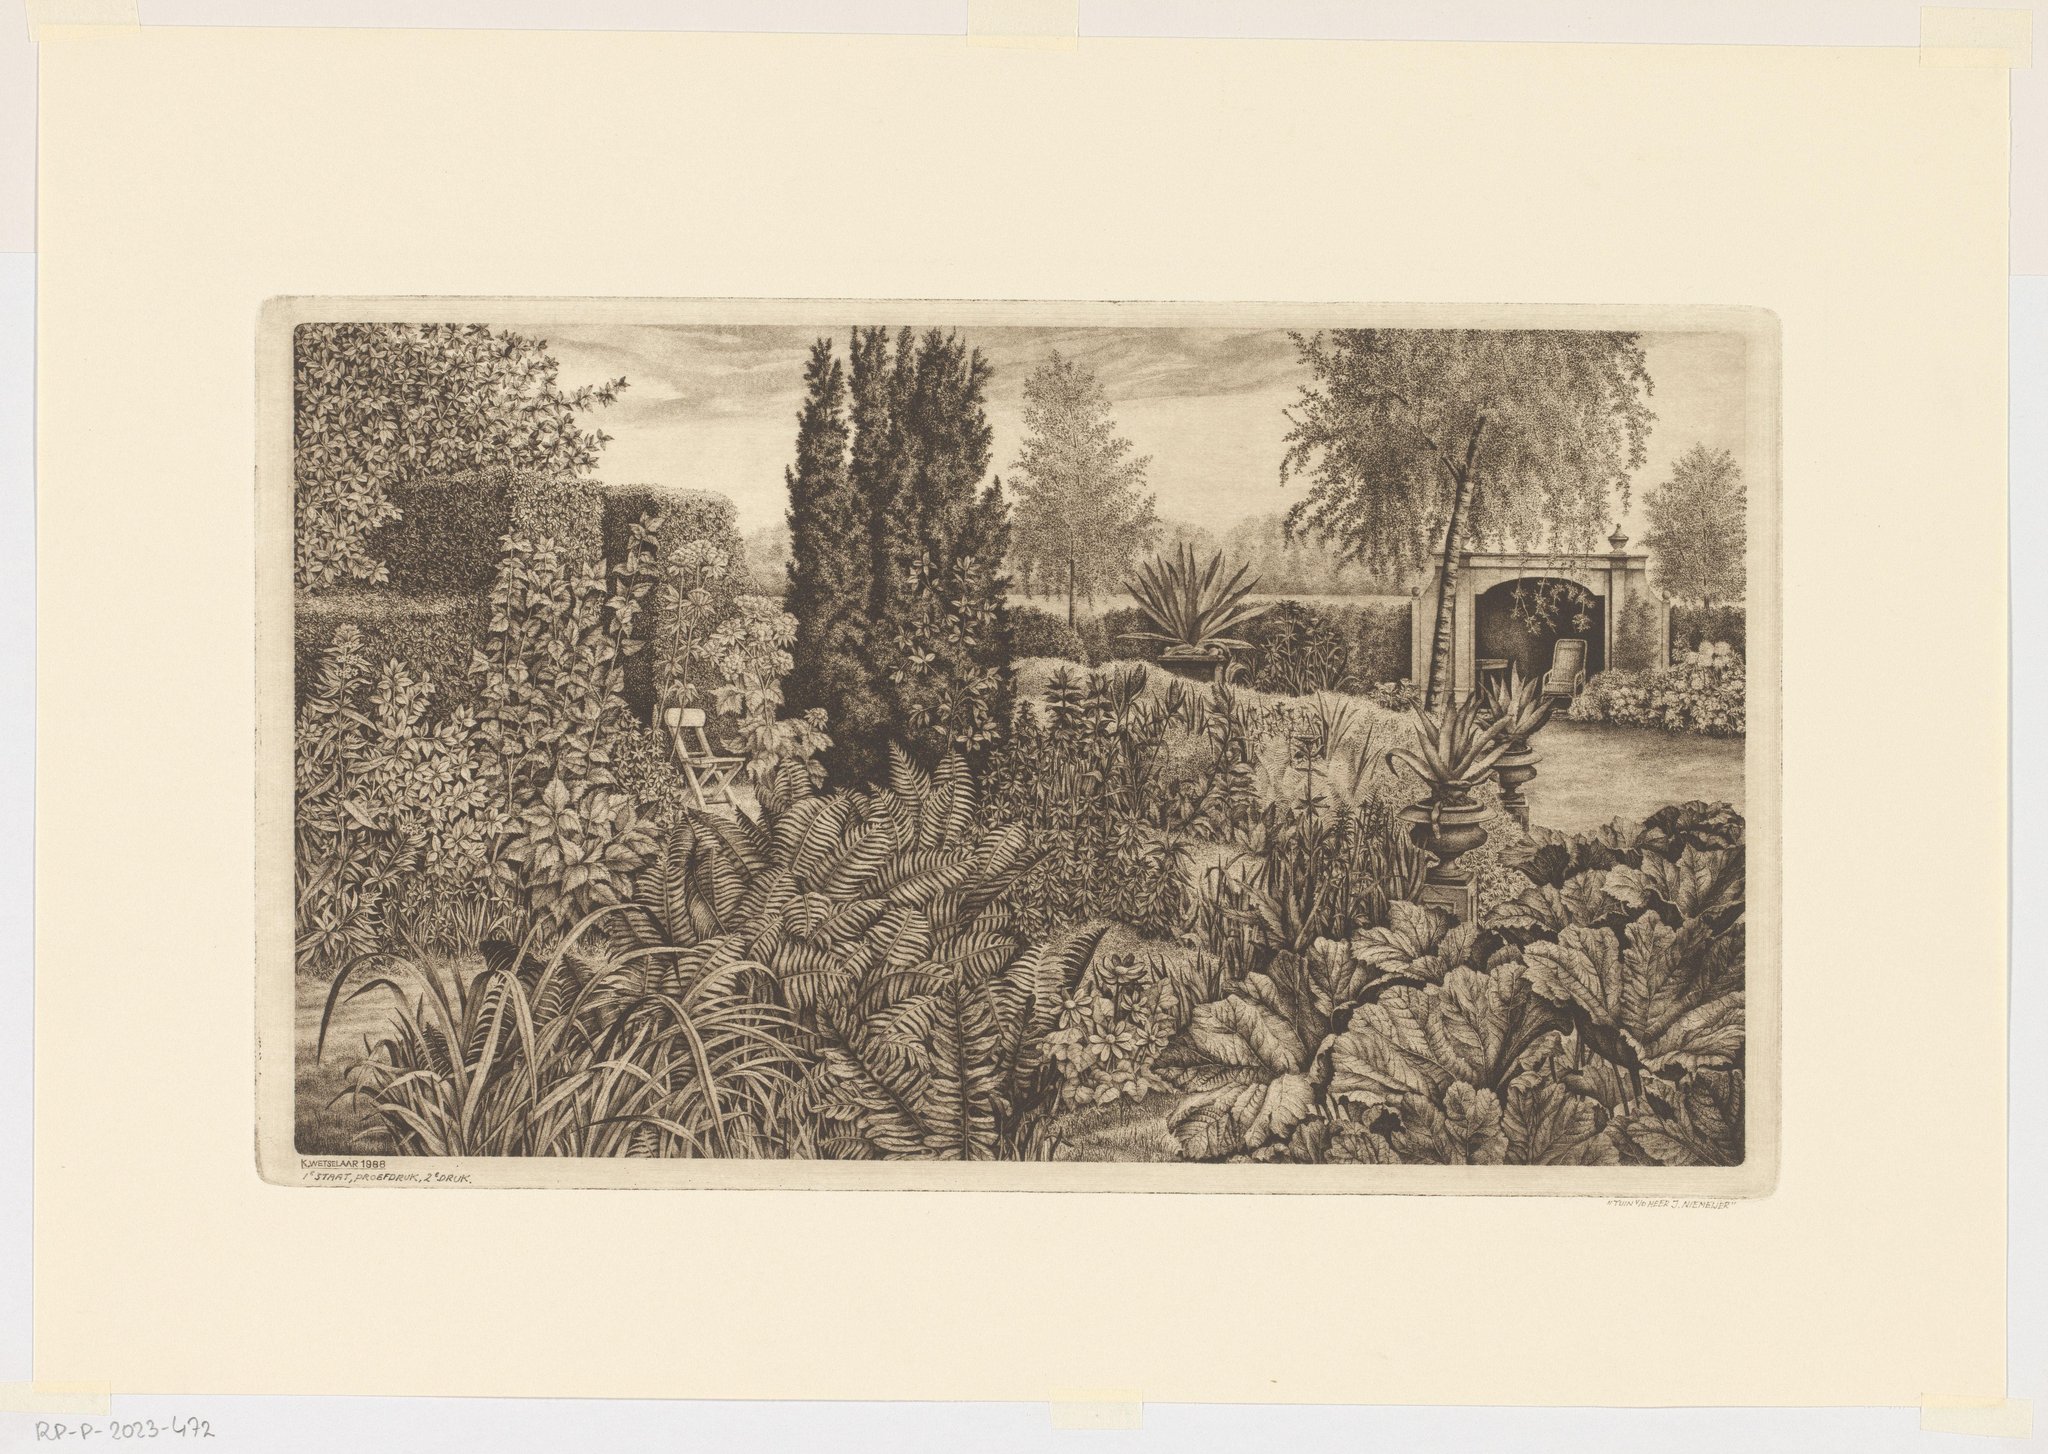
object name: print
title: Tuin v/d Heer J. Niemeijer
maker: karel wetselaar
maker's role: print maker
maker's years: 1935-2017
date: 1988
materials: paper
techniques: etching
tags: horticulture, vegetable culture, market gardening, garden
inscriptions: signature and date: ‘K. Wetselaar 1988’, inscription: ‘1e staat, proefdruk, 2e druk.’